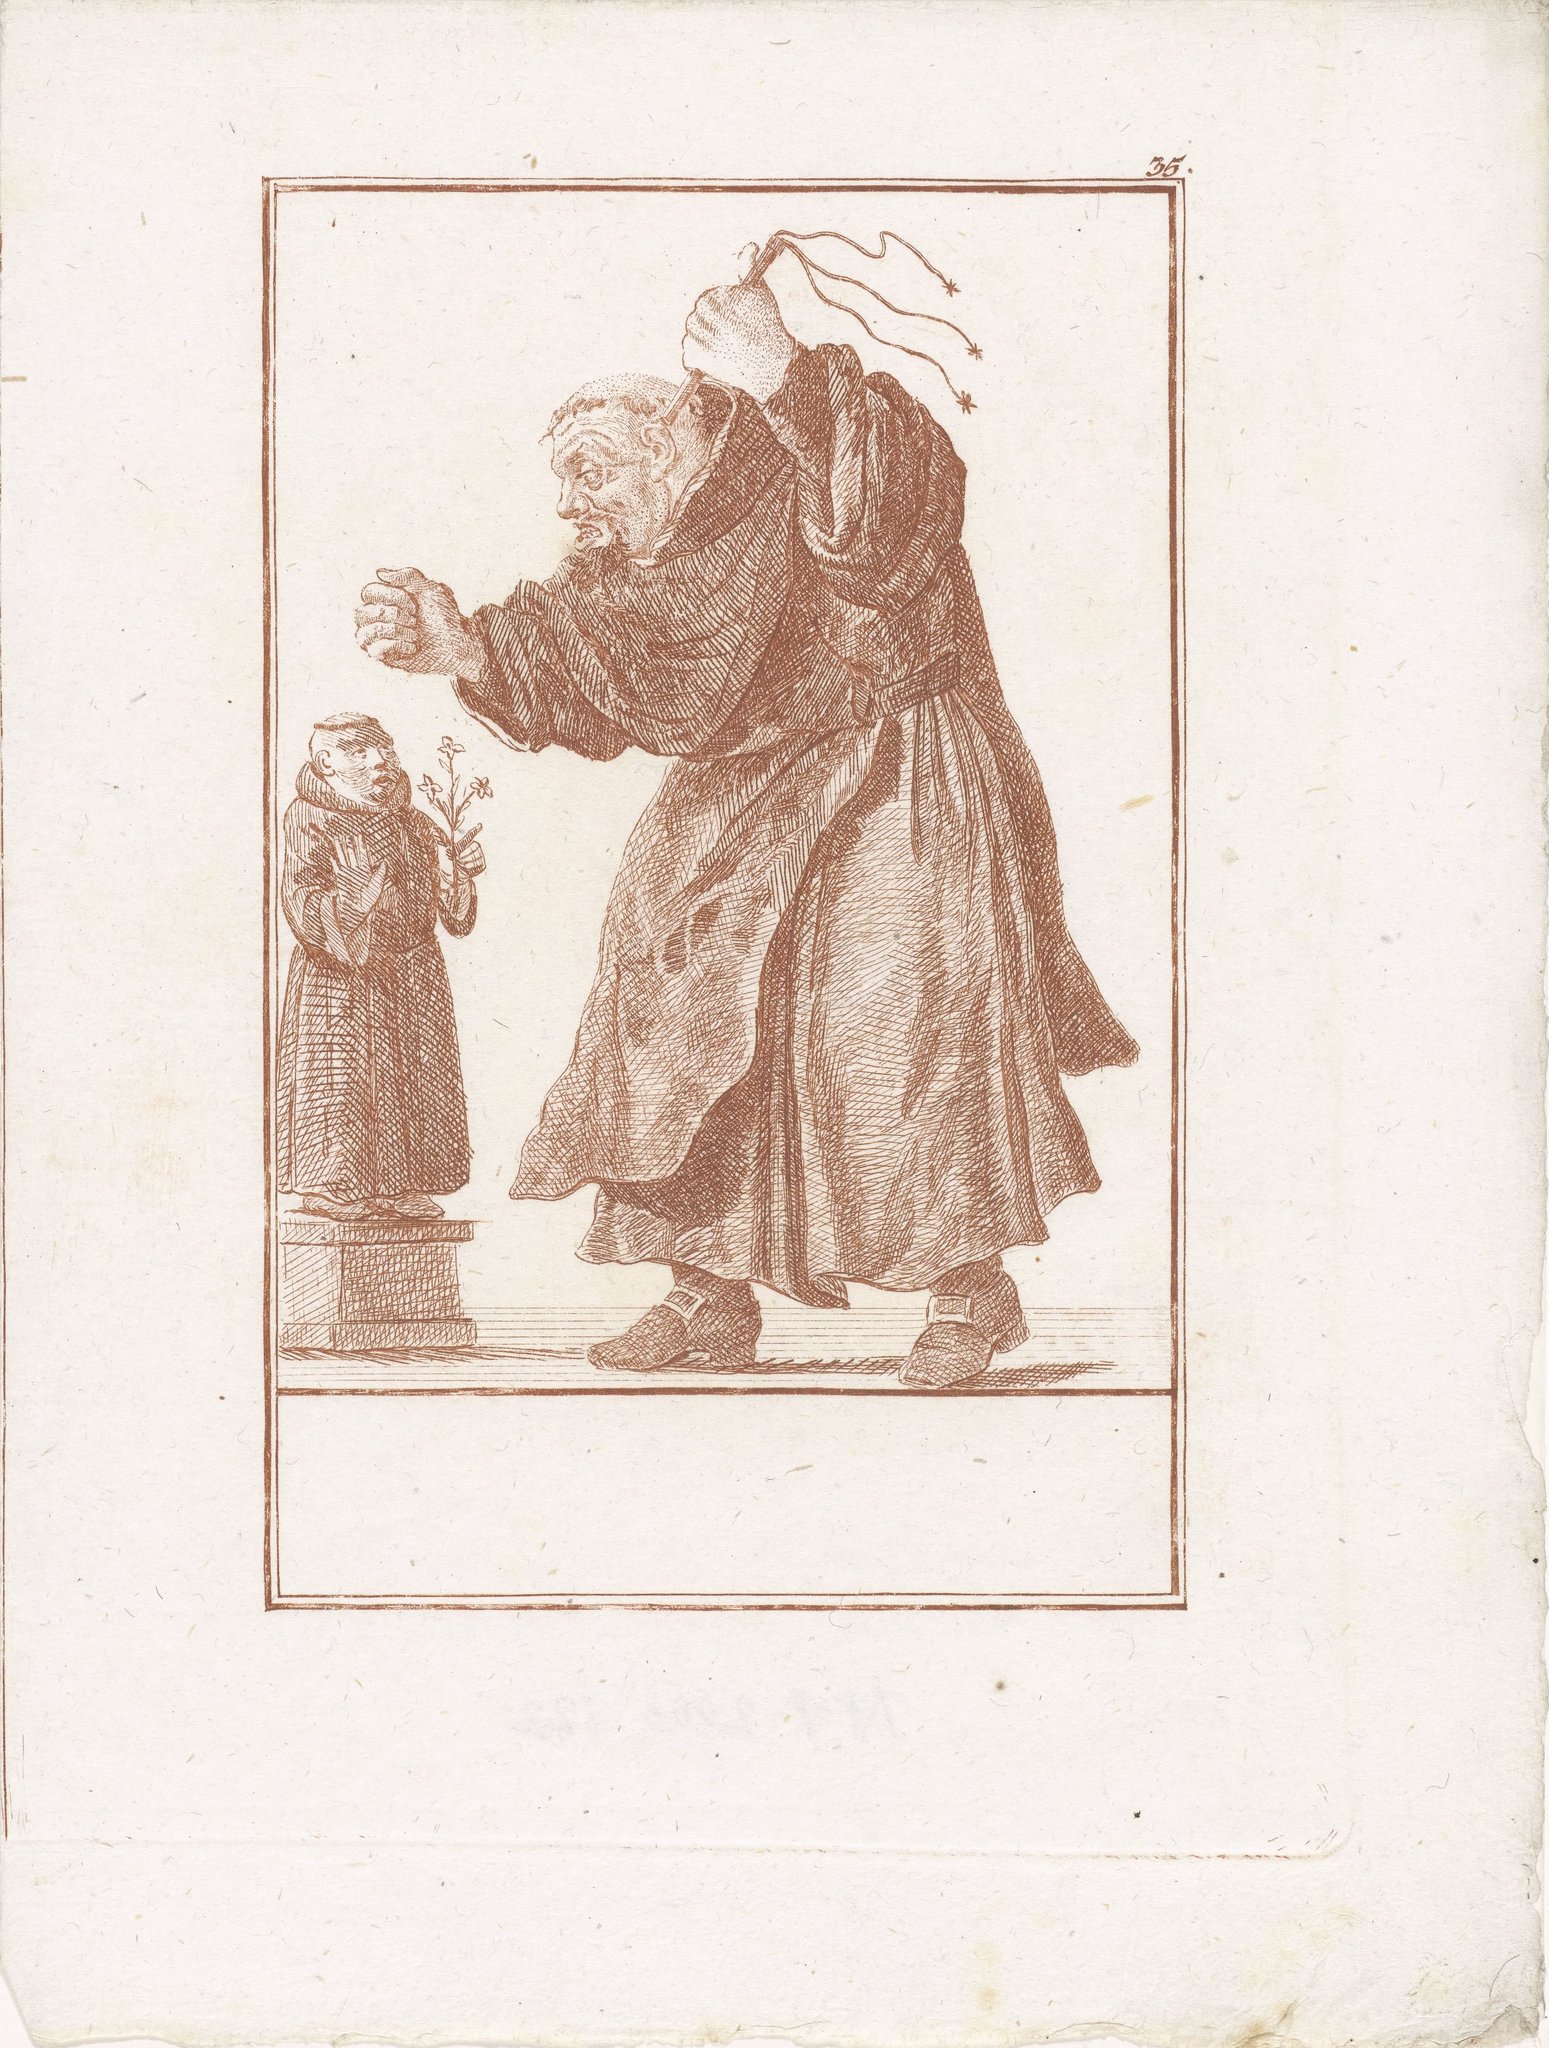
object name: print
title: Misbruiken van de katholieke geestelijkheid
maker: jacob gole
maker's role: print maker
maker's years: 1660-1724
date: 1724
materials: paper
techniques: etching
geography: amsterdam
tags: flagellants ~ ascetic life, monk(s), friar(s), (aspects of) christian religion or the church (as institution) ridiculed, criticized, or caricaturized, whip, the franciscan monk antony of padua; possible attributes: ass, book, crucifix, flowered cross, flaming heart, infant christ (on book), lily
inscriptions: collector's mark: Lugt 2228, collector's mark: Lugt 2760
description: Een monnik met een baard staat voor een beeld van de heilige Antonius van Padua. Hij heeft een gesel in de hand. In plaats van zichzelf te geselen zwaait hij het wapen in de richting van het beeld. De prent is deel van een 50-delige serie met als onderwerp de misbruiken van de katholieke geestelijkheid.